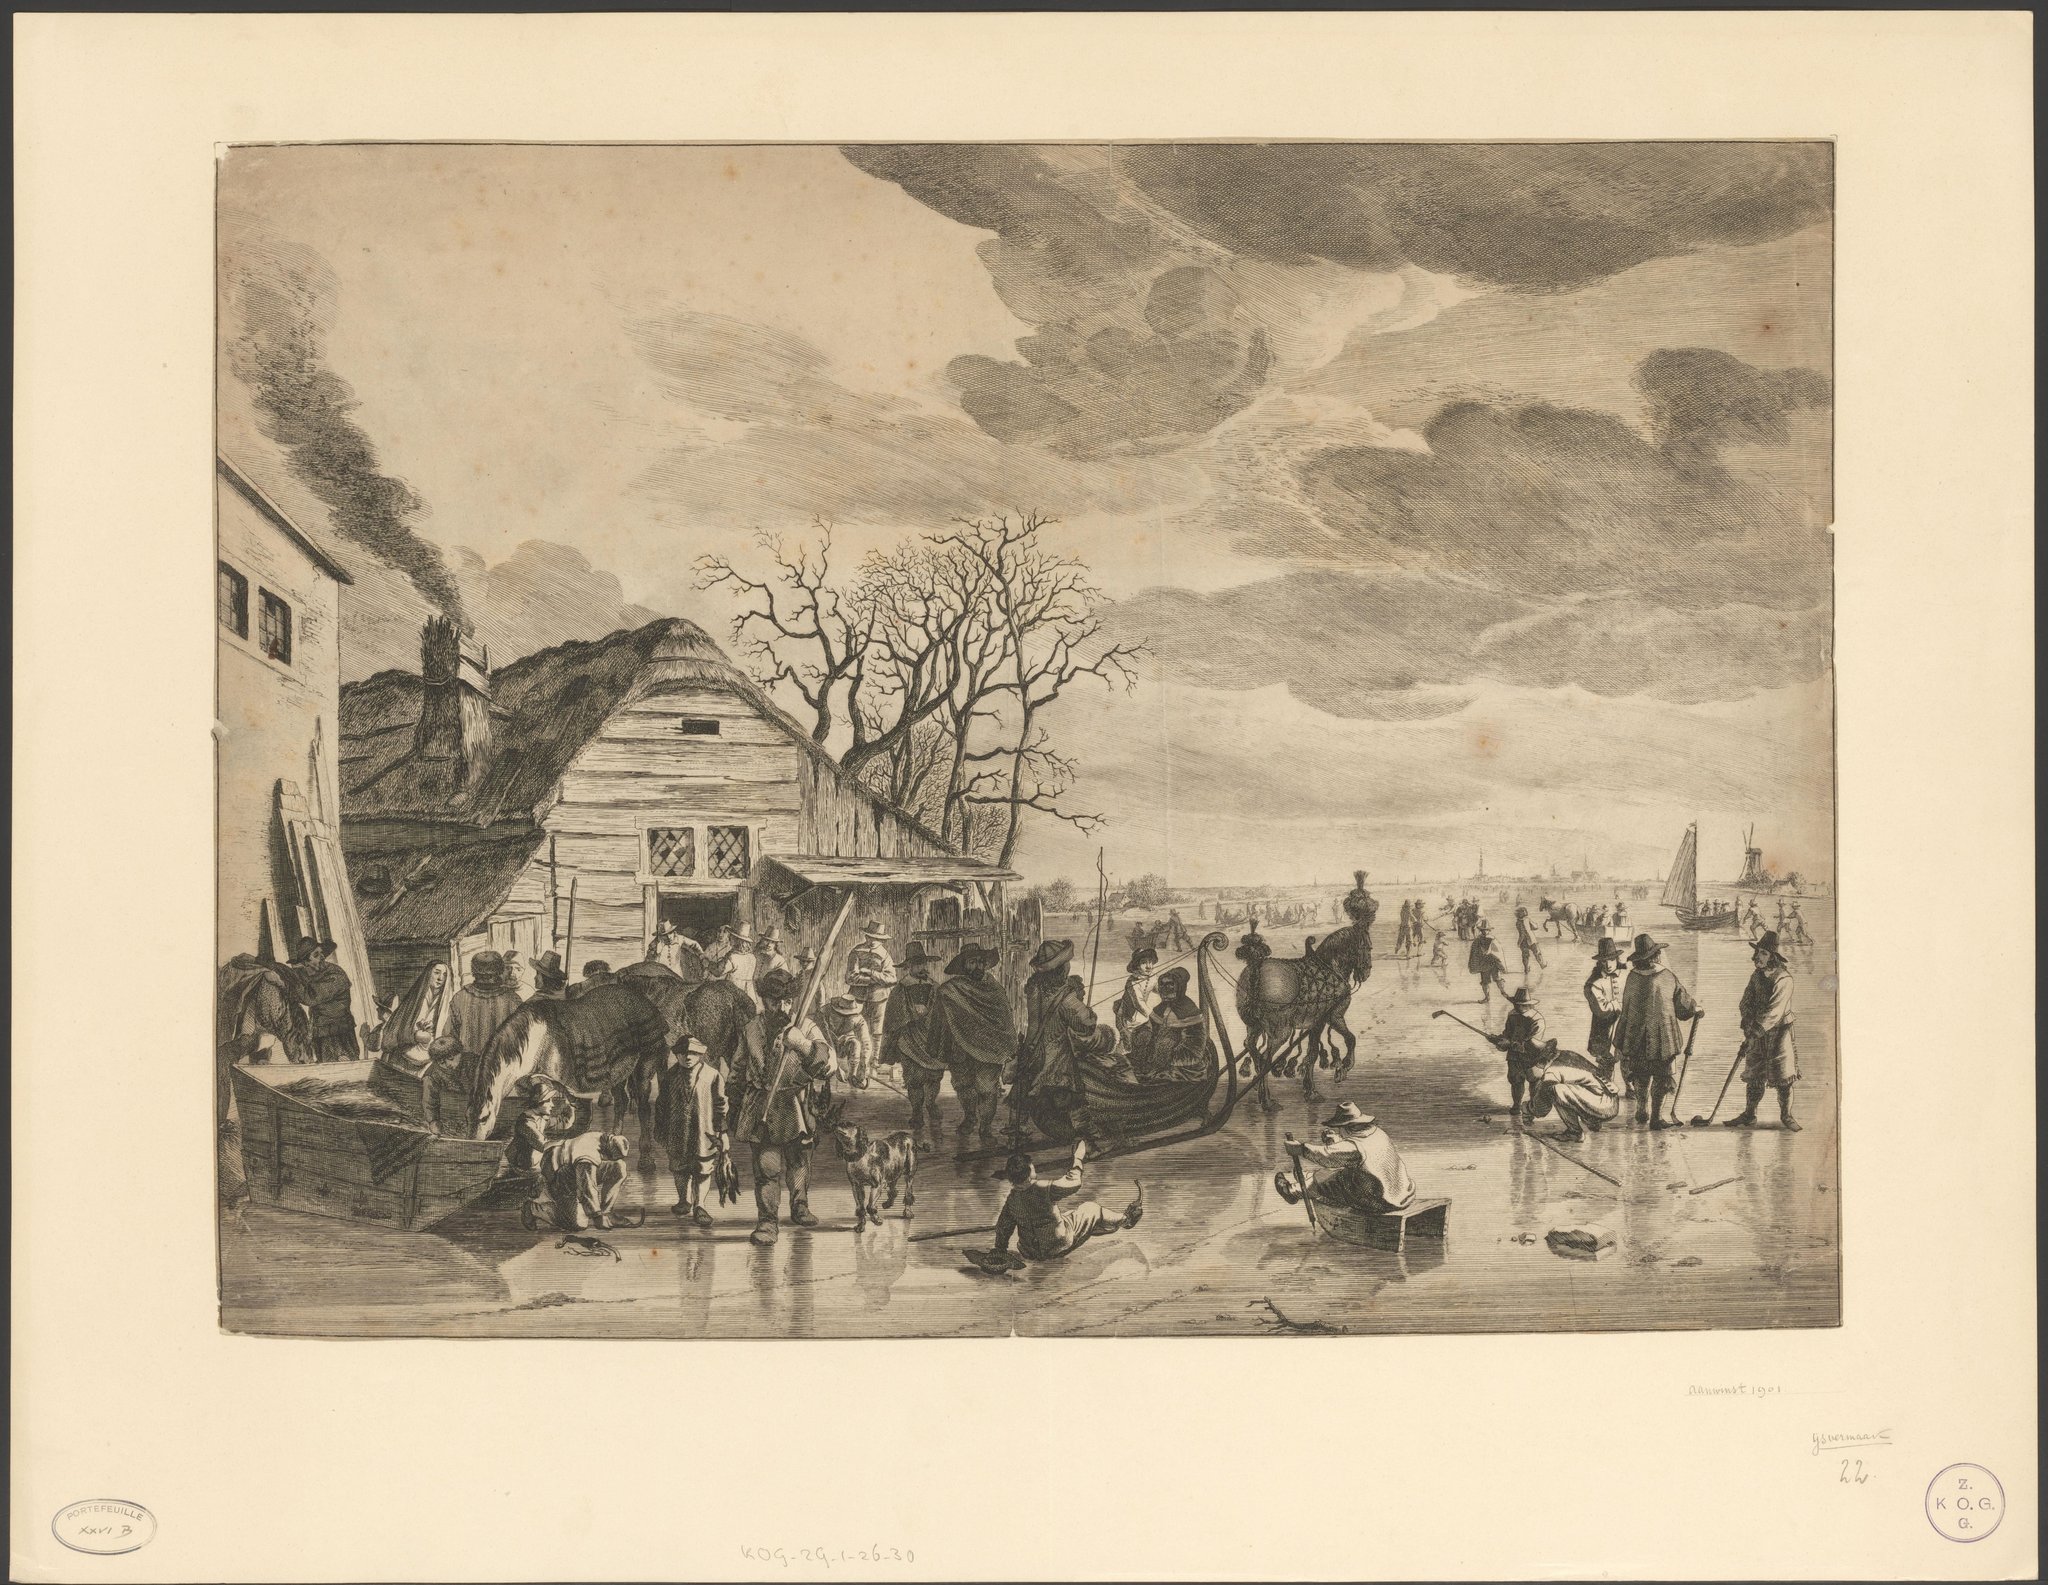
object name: print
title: IJsvermaak: de maand januari en het element lucht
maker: pieter nolpe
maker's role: draughtsman, print maker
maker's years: 1613-1653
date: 1623-1653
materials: paper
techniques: engraving, etching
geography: netherlands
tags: ice-sailing (winter sports), sleigh, sledge (non-sport), ice ~ freezing weather, skates (winter sports), sledge, sleigh (winter sports), severe winters, small sleigh (winter sports)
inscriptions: collector's mark, collector's mark: Lugt 1641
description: Op het ijs vermaken mensen zich met kolven, rijden in een slede en ijszeilen. Links verzamelen mensen zich bij een uitspanning. Zonder het onderschrift. Prent uit een serie van verschillende maanden, die eveneens een element of seizoen verbeelden. Onderwerpsrubrieken binnen de Atlas Zeden en Gewoonten: Spel en Vermaak; IJsvermaak, Riviergezichten.